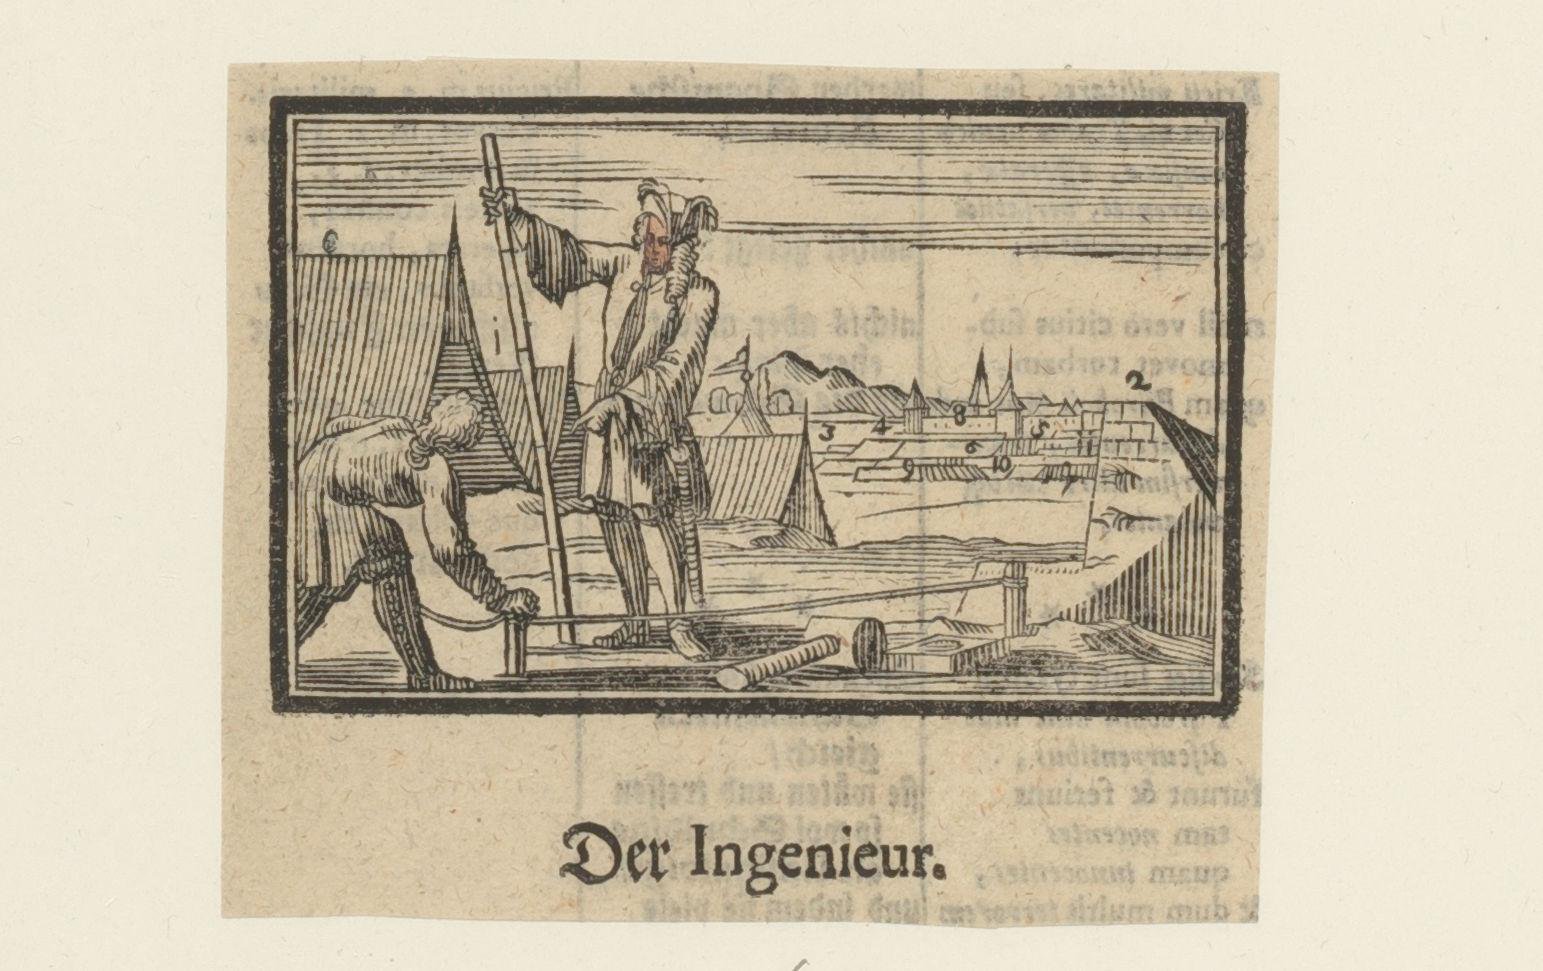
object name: book illustration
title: Ingenieur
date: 1719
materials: paper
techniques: letterpress printing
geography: nuremberg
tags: handicrafts, craftsman at work, engineering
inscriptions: collector's mark: Lugt 1641, stamp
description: Op een stadswal zijn een ingenieur en een medewerker bezig met opmetingen. Op de achtergrond zijn voorbeelden van zijn werk te zien, zoals: verdedigingswerken om legerkampen, steden en vestingen. Onderwerpsrubrieken binnen de Atlas Zeden en Gewoonten: Handel, Nijverheid en Verkeer, Beroep en bedrijf, Complete suites.